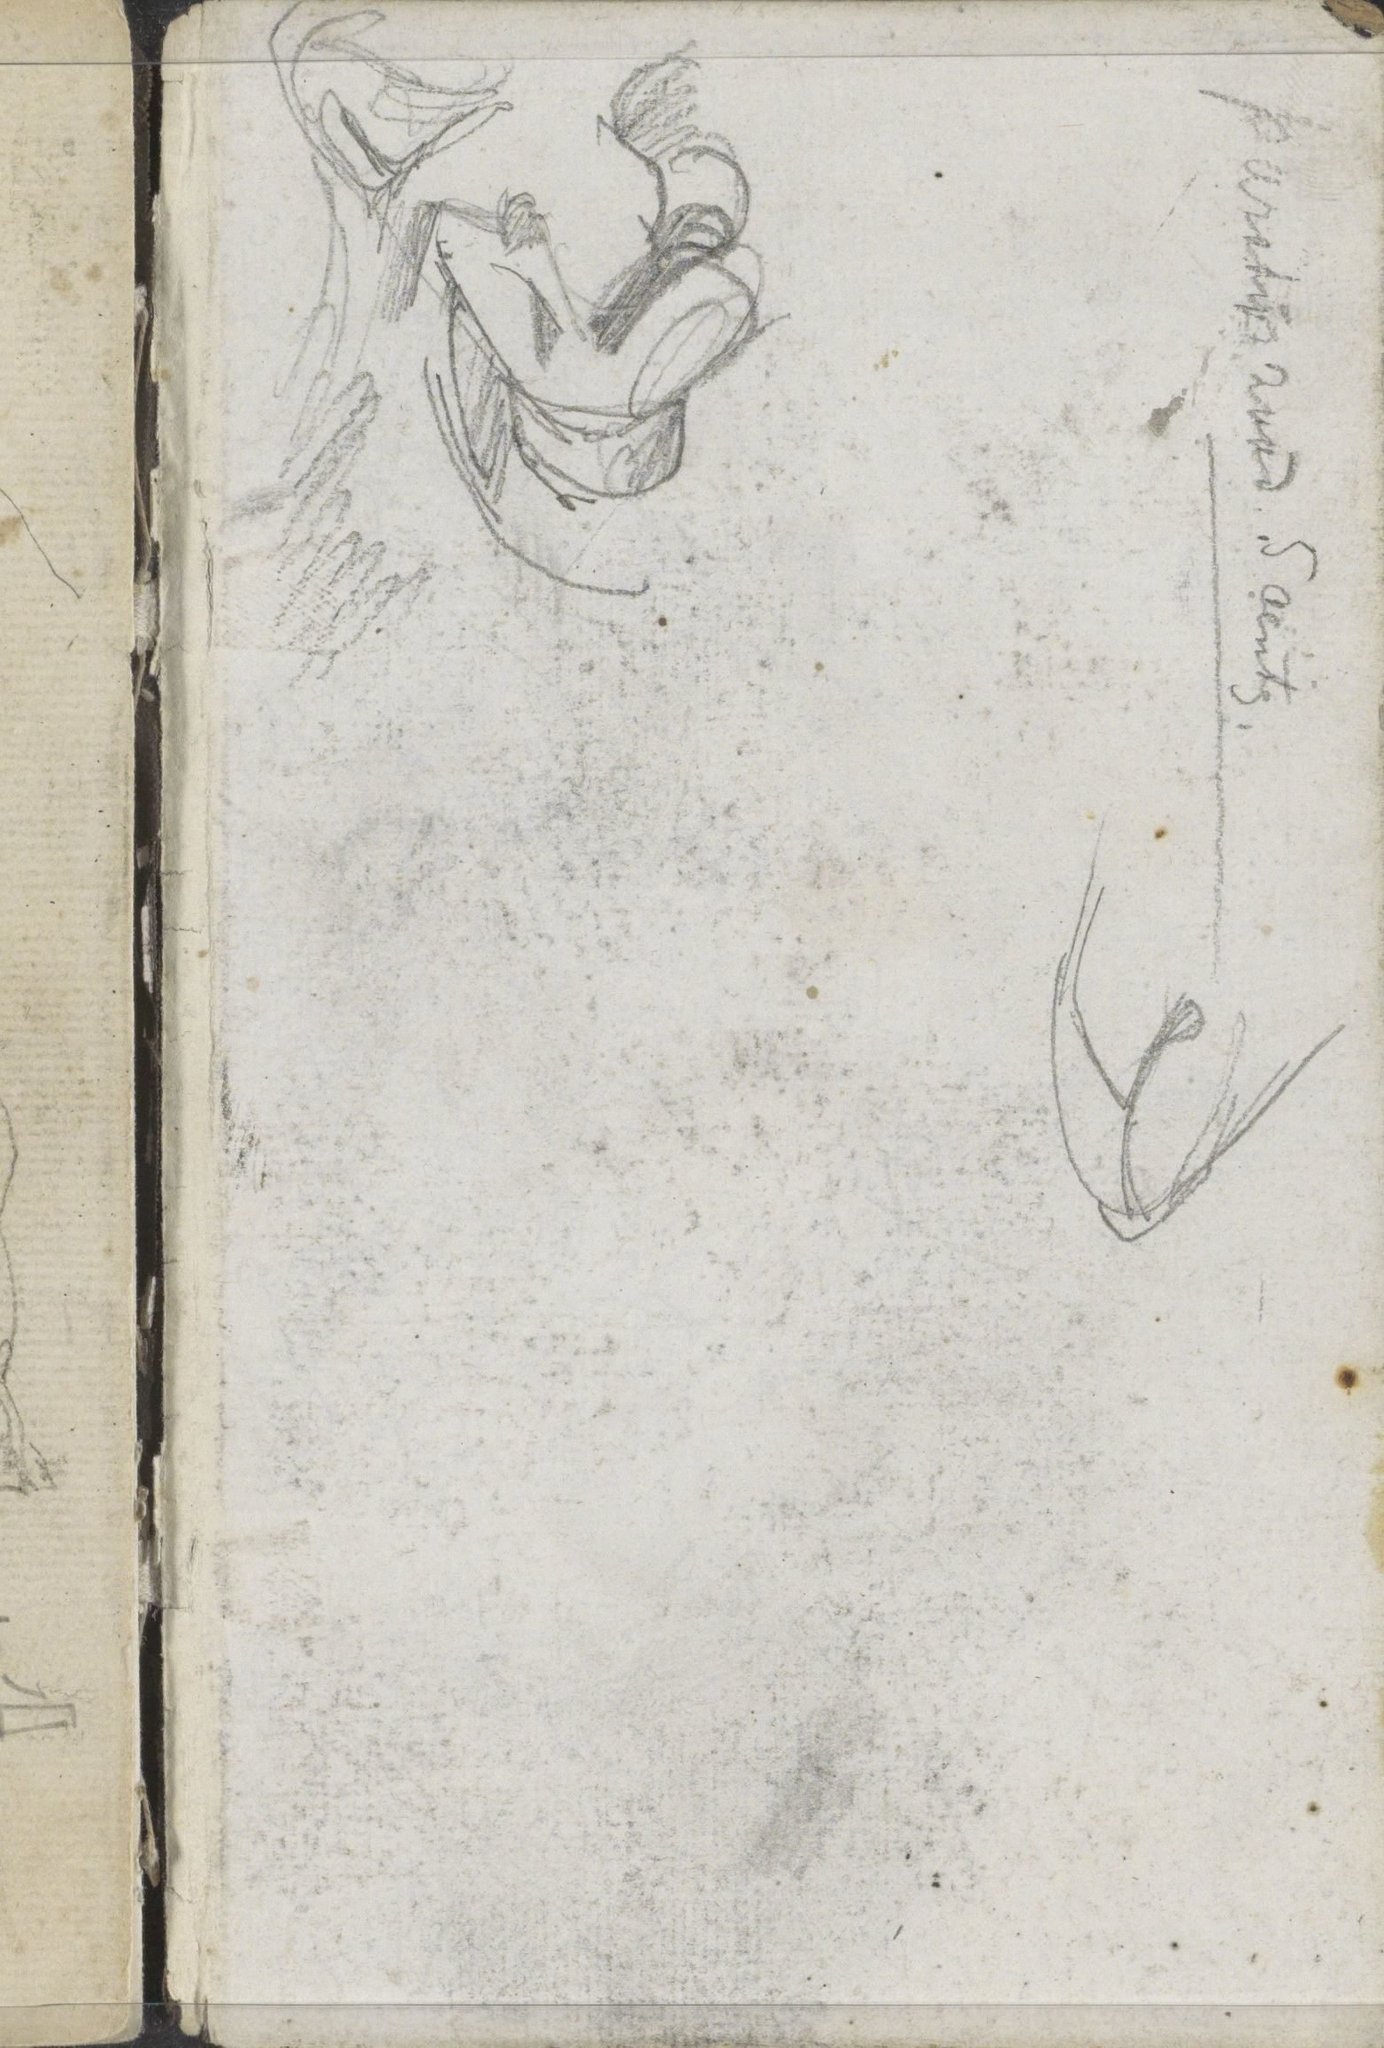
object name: endleaf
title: Twee studies van een kameel of dromedaris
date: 1880-1882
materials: paper, pencil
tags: hoofed animals: camel, hoofed animals: dromedary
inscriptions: annotation: ‘paradijszaad [...]’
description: Schutblad B, achterste schutblad, uit een schetsboek met 10 bladen.